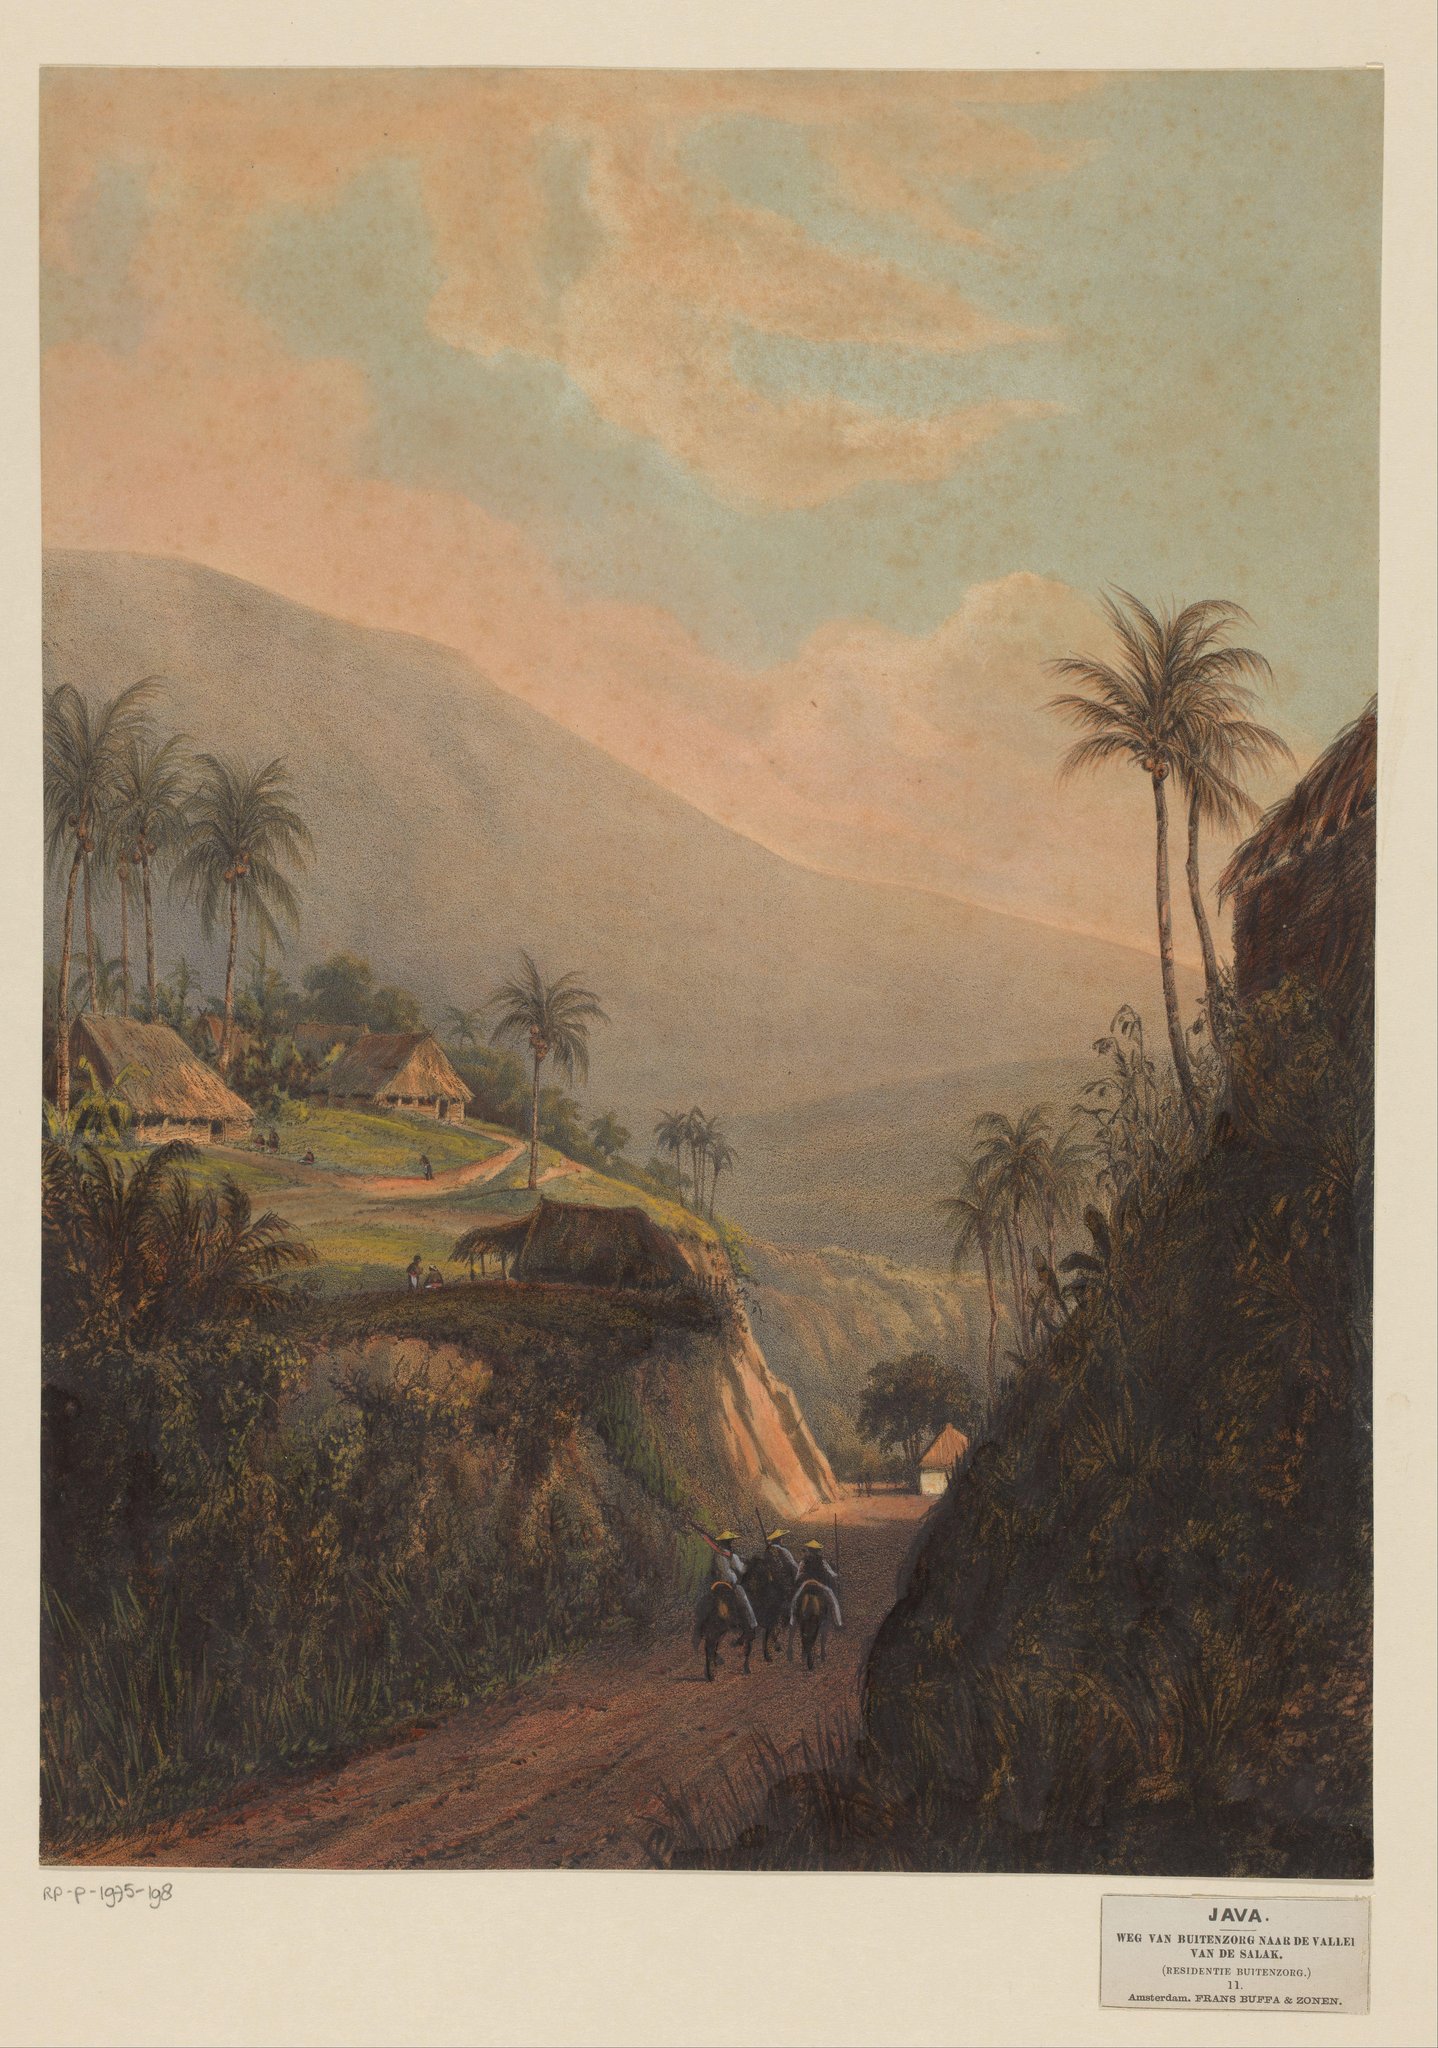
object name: print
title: Weg van buitenzorg naar de vallei van de Salak (residentie Buitenzorg)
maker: johan conrad greive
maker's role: draughtsman, painter, print maker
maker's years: 1837-1891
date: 1869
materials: paper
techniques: lithograph, hand coloring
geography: amsterdam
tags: landscapes in tropical and sub-tropical regions, java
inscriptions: collector's mark: Lugt 2228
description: Op de weg drie ruiters, links enkele huizen met daken van stro. De prent maakt deel uit van een omslag met een tekstblad en 24 losse prenten.